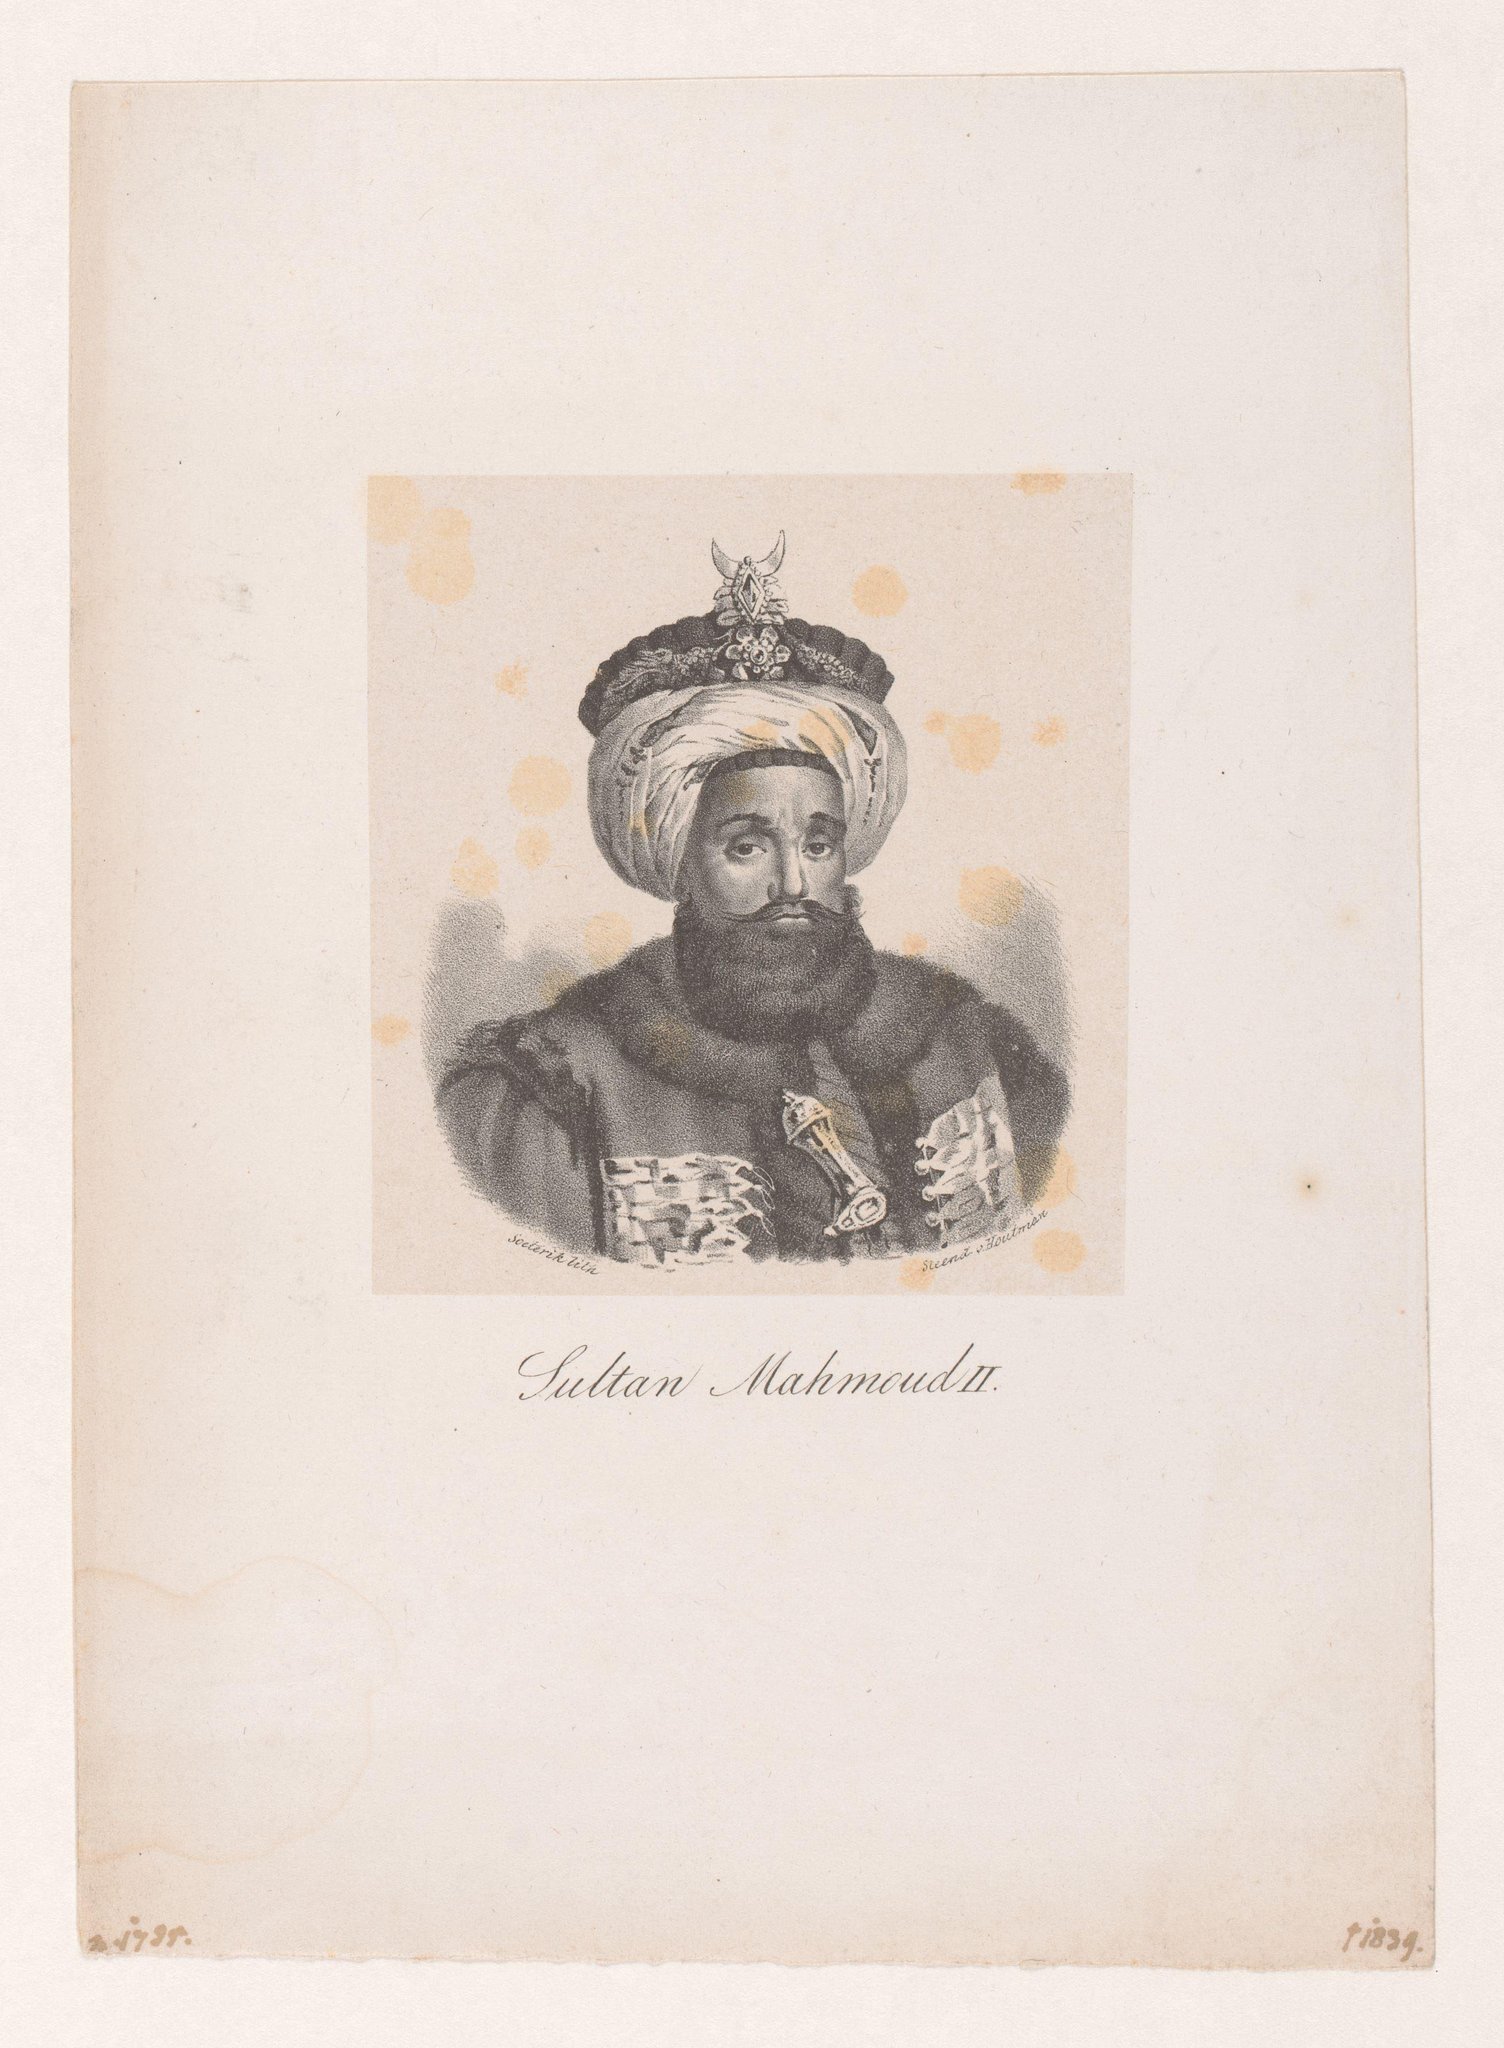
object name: print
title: Portret van Sultan Mahmud II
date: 1828-1839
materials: paper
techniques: lithograph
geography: utrecht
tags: historical persons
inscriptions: collector's mark: Lugt 2228